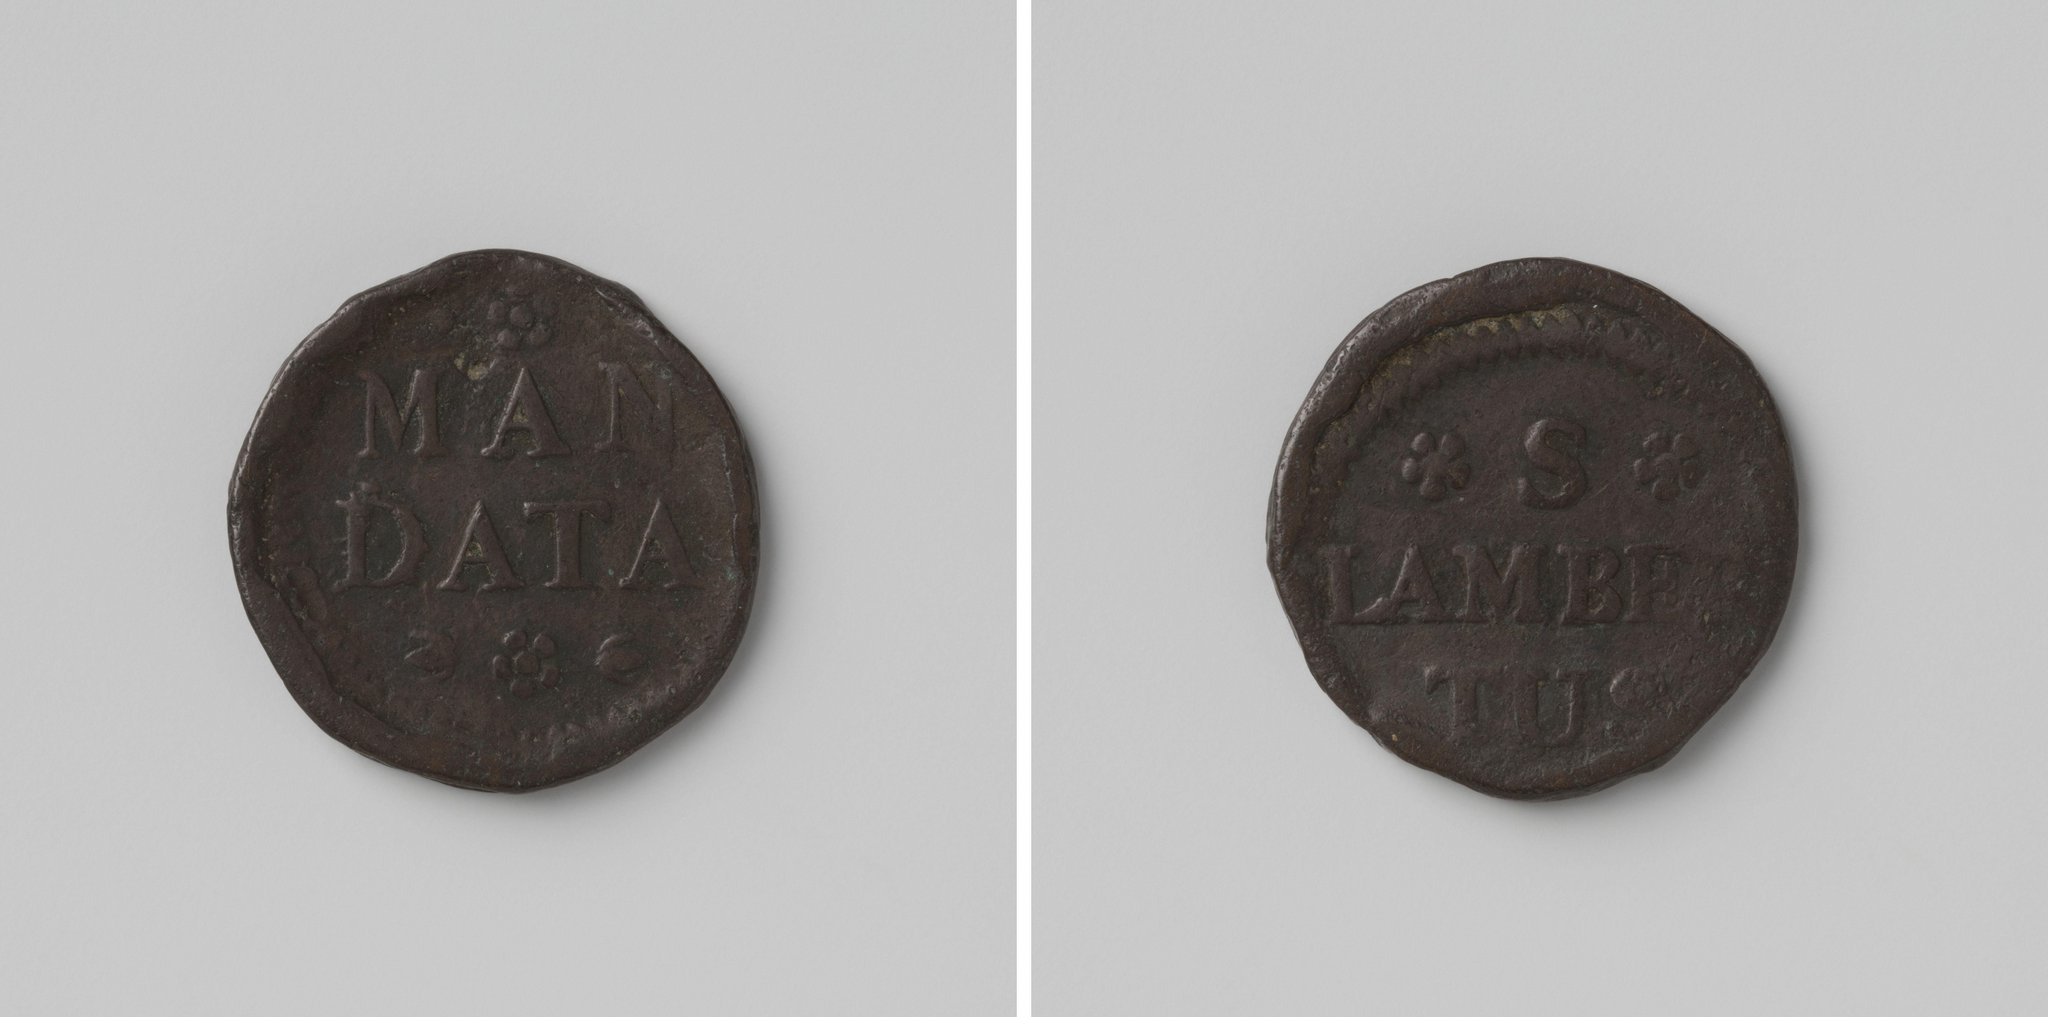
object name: alms token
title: Armenpenning voor brood, van het Sint-Lambertuskapittel te Luik.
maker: Anonymous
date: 1709-1724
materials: copper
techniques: striking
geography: liège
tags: sint-lambertuskathedraal (luik)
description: Koperen penning. Voorzijde: opschrift onder twee rozetten binnen bladerkrans. Keerzijde: opschrift onder rozet tussen twee punten en boven rozet tussen twee bloemen binnen bladerkrans